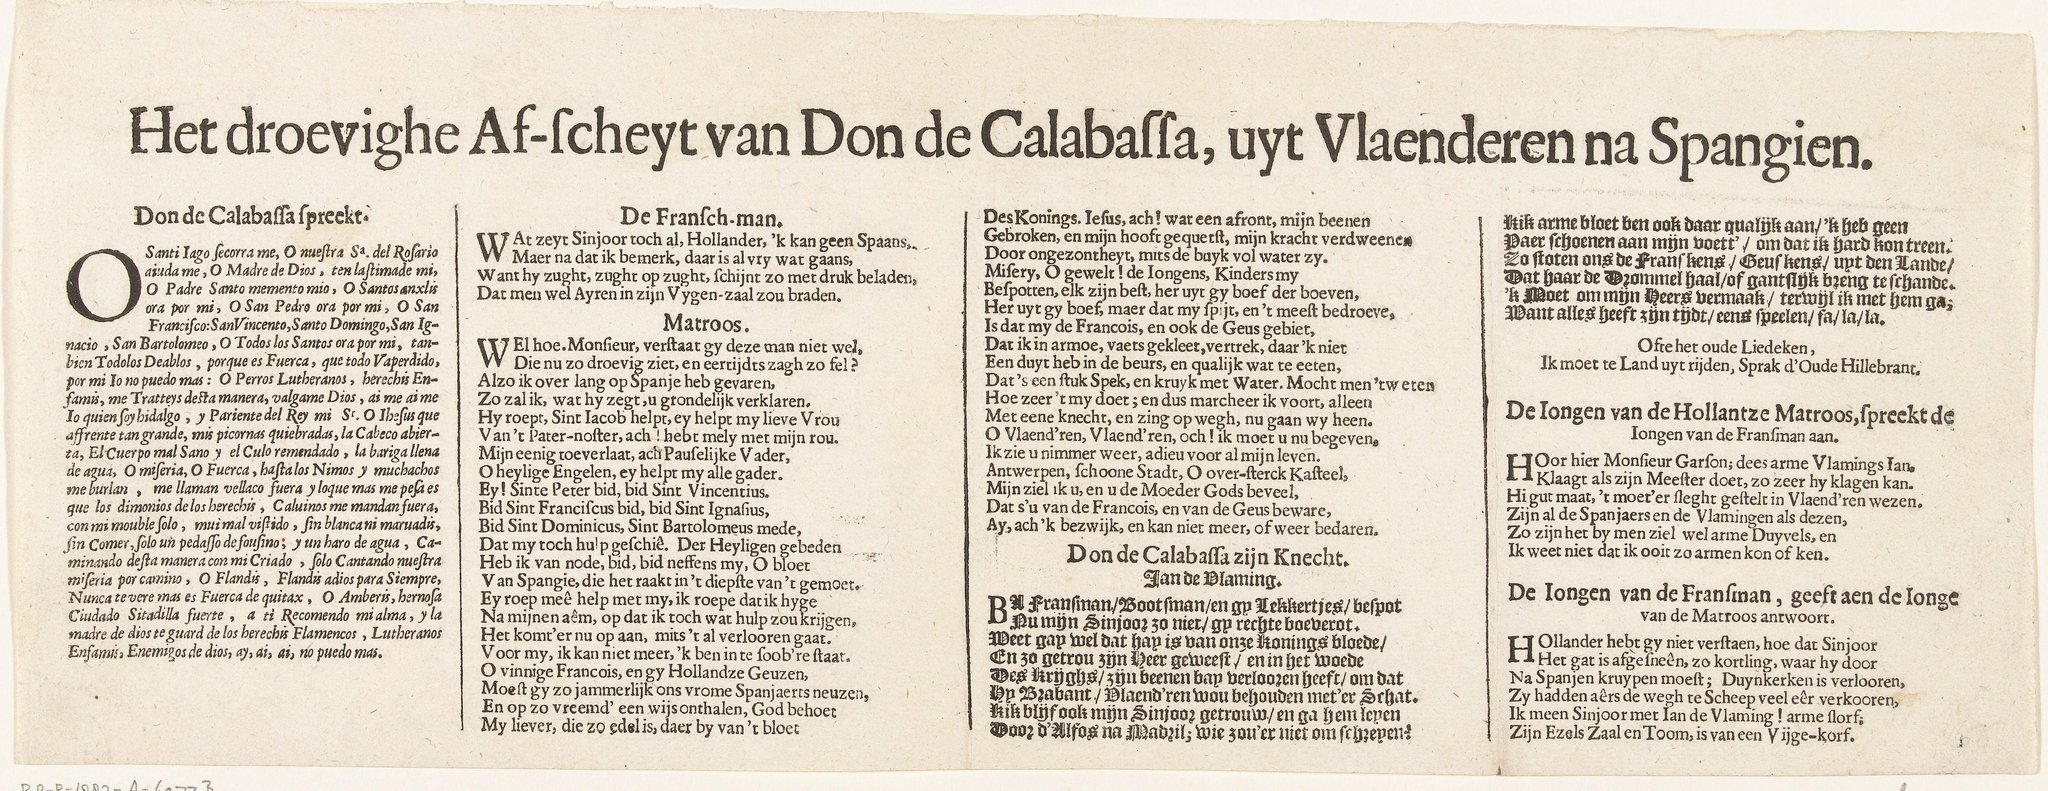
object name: text sheet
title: Tekstblad bij de prent van het droevig afscheid van Don de Calabassa uit Vlaanderen en terugkeer naar Spanje, 1646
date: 1646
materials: paper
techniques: letterpress printing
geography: northern netherlands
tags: duinkerke, inname van duinkerken (1646), dertigjarige oorlog, tachtigjarige oorlog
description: Tekstblad bij de prent van het droevig afscheid van Don de Calabassa uit Vlaanderen en terugkeer naar Spanje. Spotprent op de Spanjaarden na het verlies van Duinkerken aan de Fransen in 1646. Blad met tekst in 4 kolommen in het Nederlands waarin de afgebeelde personen spreken.